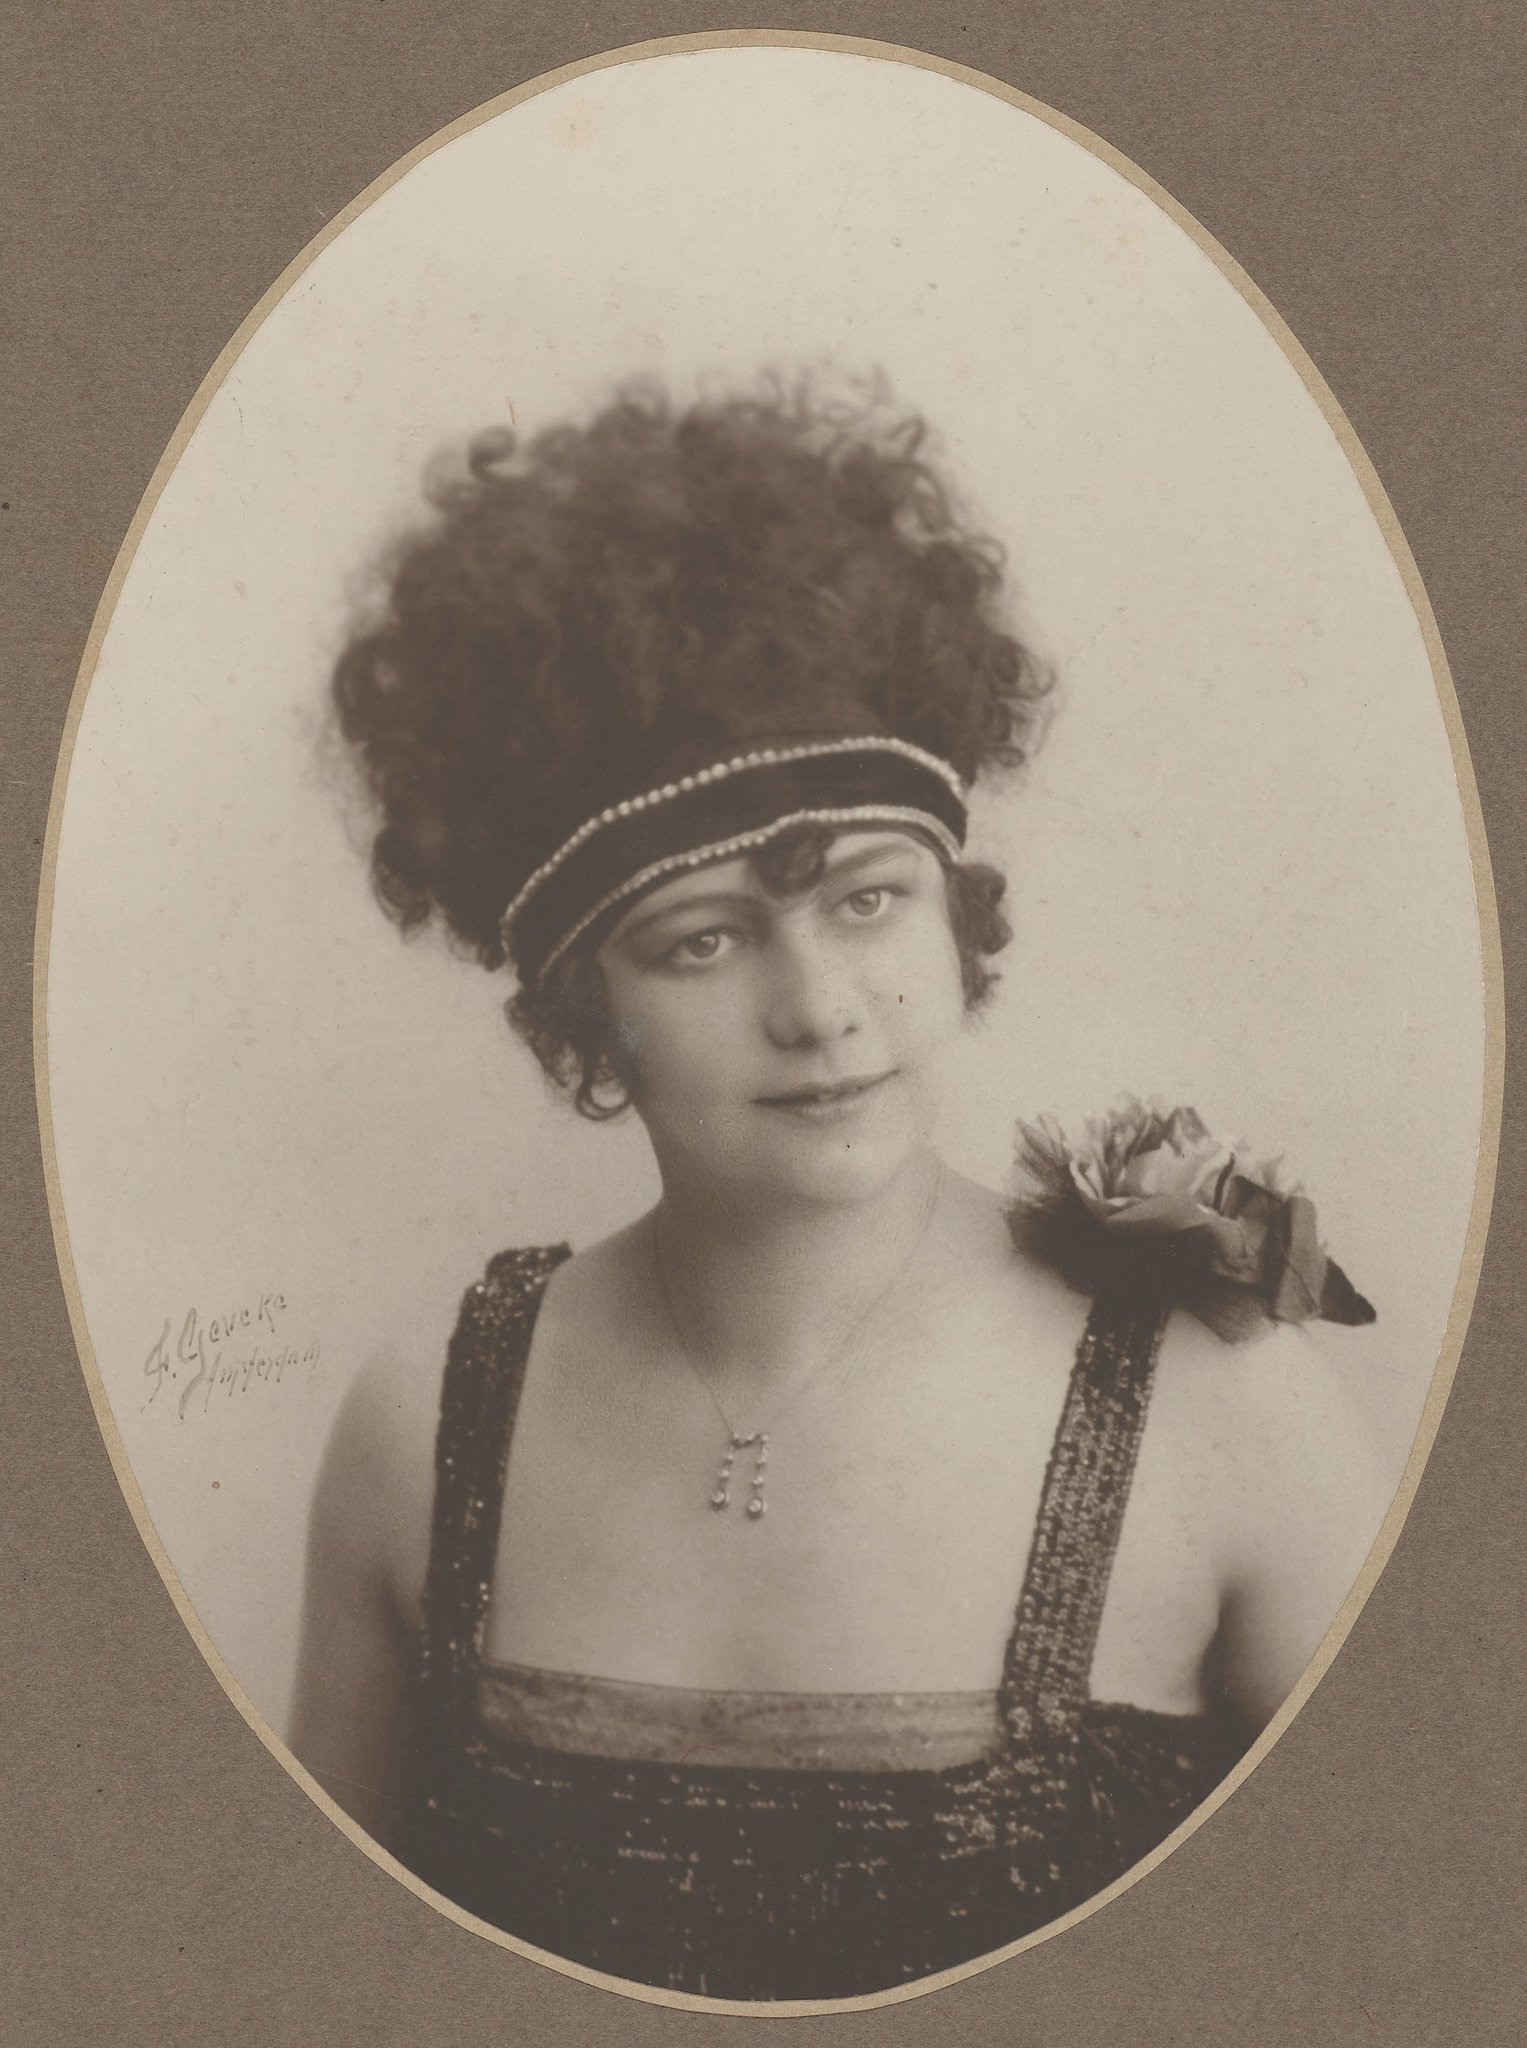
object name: photograph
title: Ovaal portret van de cabaretière Louisette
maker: frits geveke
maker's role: fotograaf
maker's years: 1878-1950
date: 1910-1940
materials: paper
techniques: gelatin silver print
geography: amsterdam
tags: historical persons (portraits and scenes from the life) - bb - woman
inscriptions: title: ‘Louisette’, name: ‘F. Geveke Amsterdam’